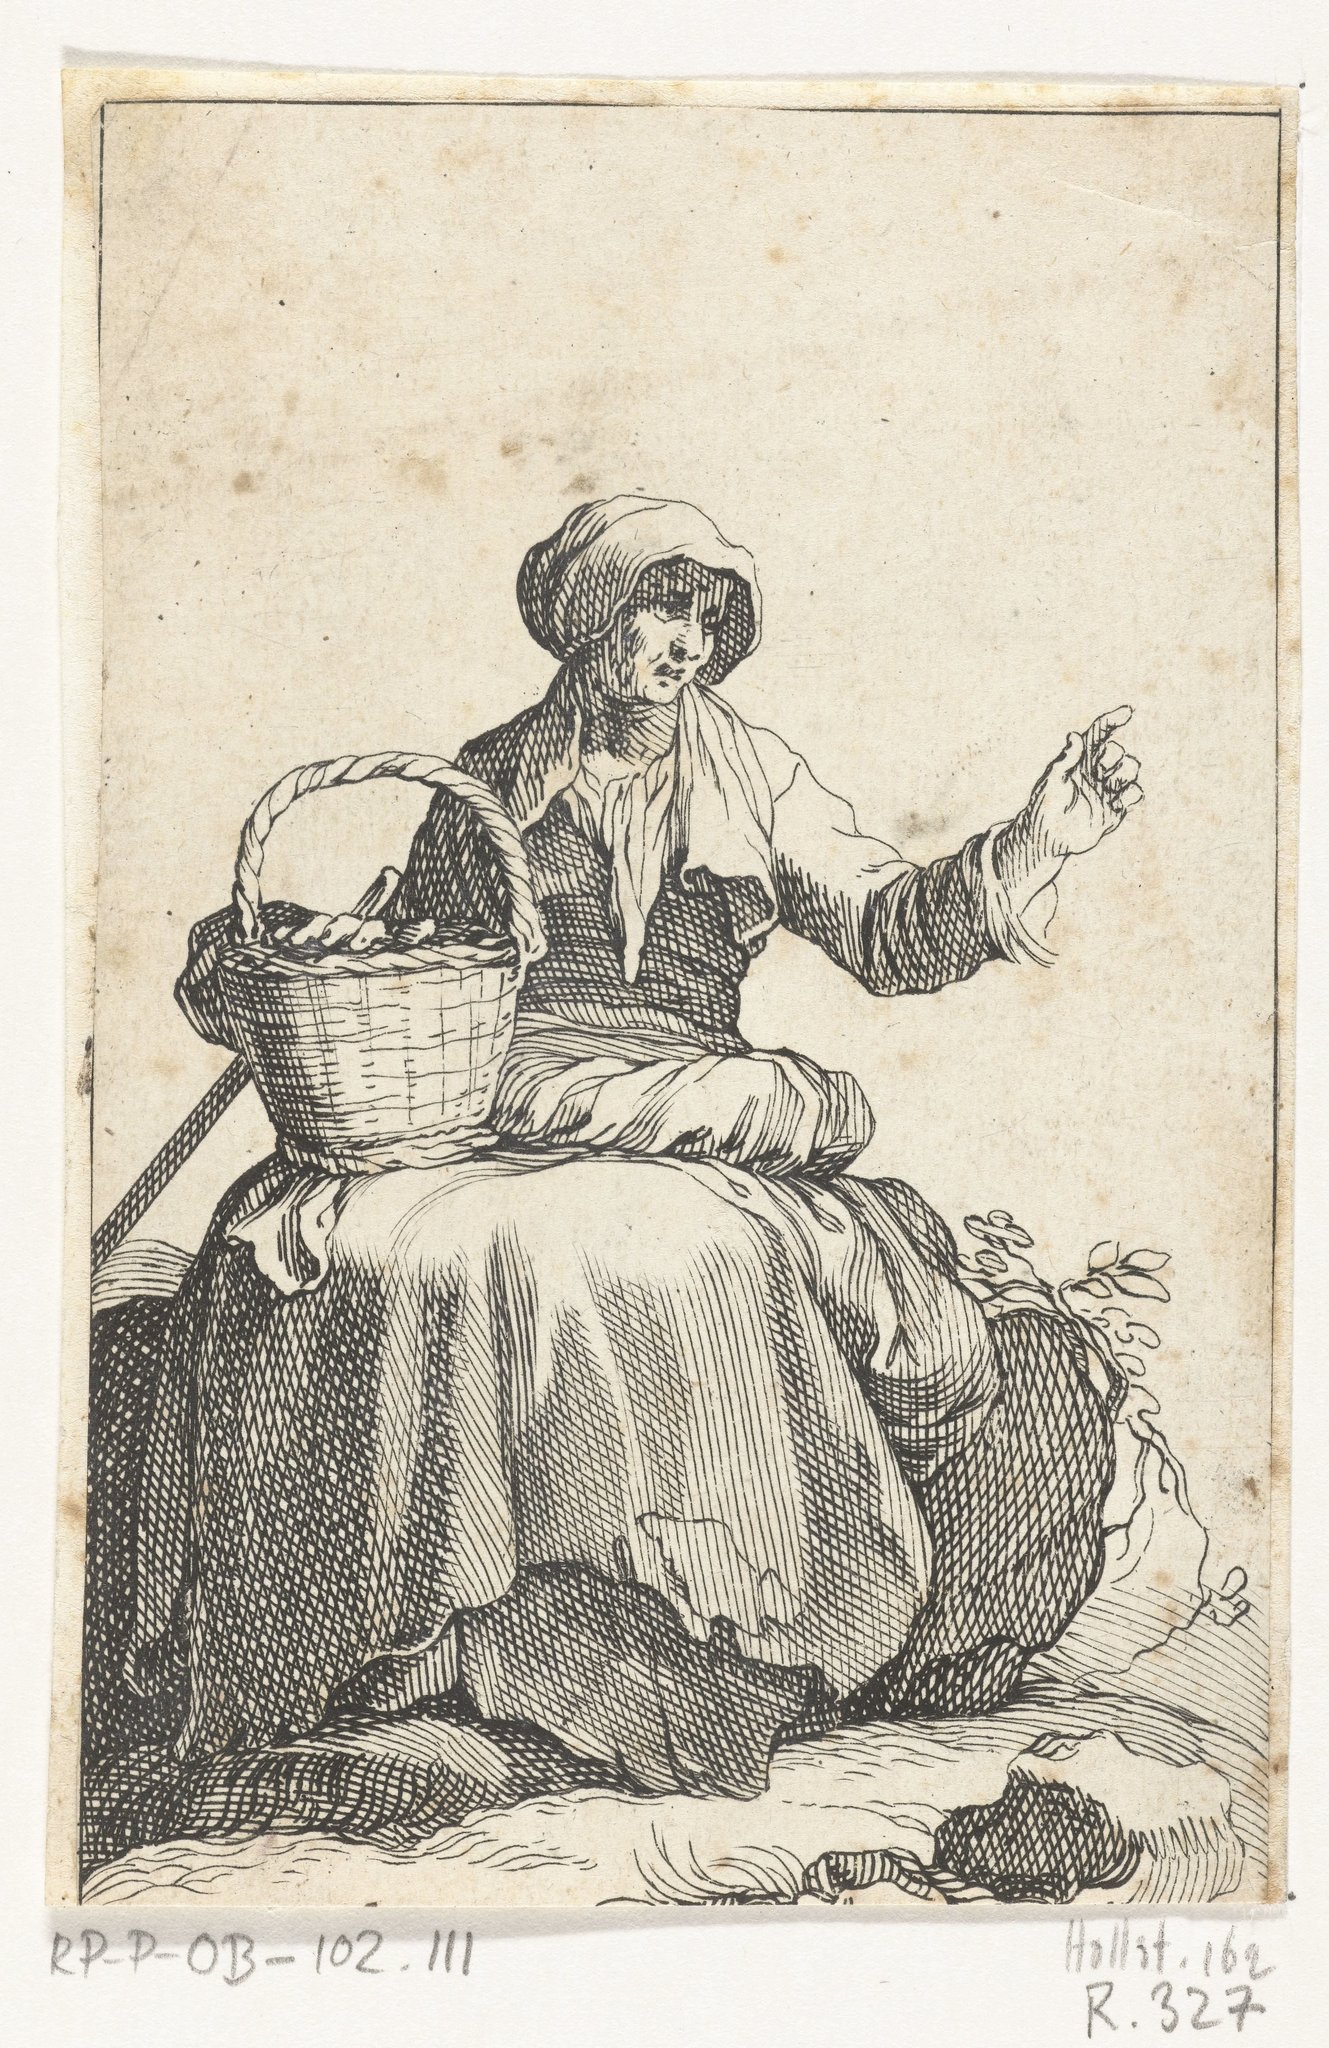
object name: print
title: De kleine figuren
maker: frederick bloemaert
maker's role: print maker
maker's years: 1614-1669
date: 1635-1669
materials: paper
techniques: engraving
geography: utrecht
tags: old woman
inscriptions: collector's mark: Lugt 2228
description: Een zittende vrouw, met stok en mand op schoot, wijst met haar linkerhand in de verte.